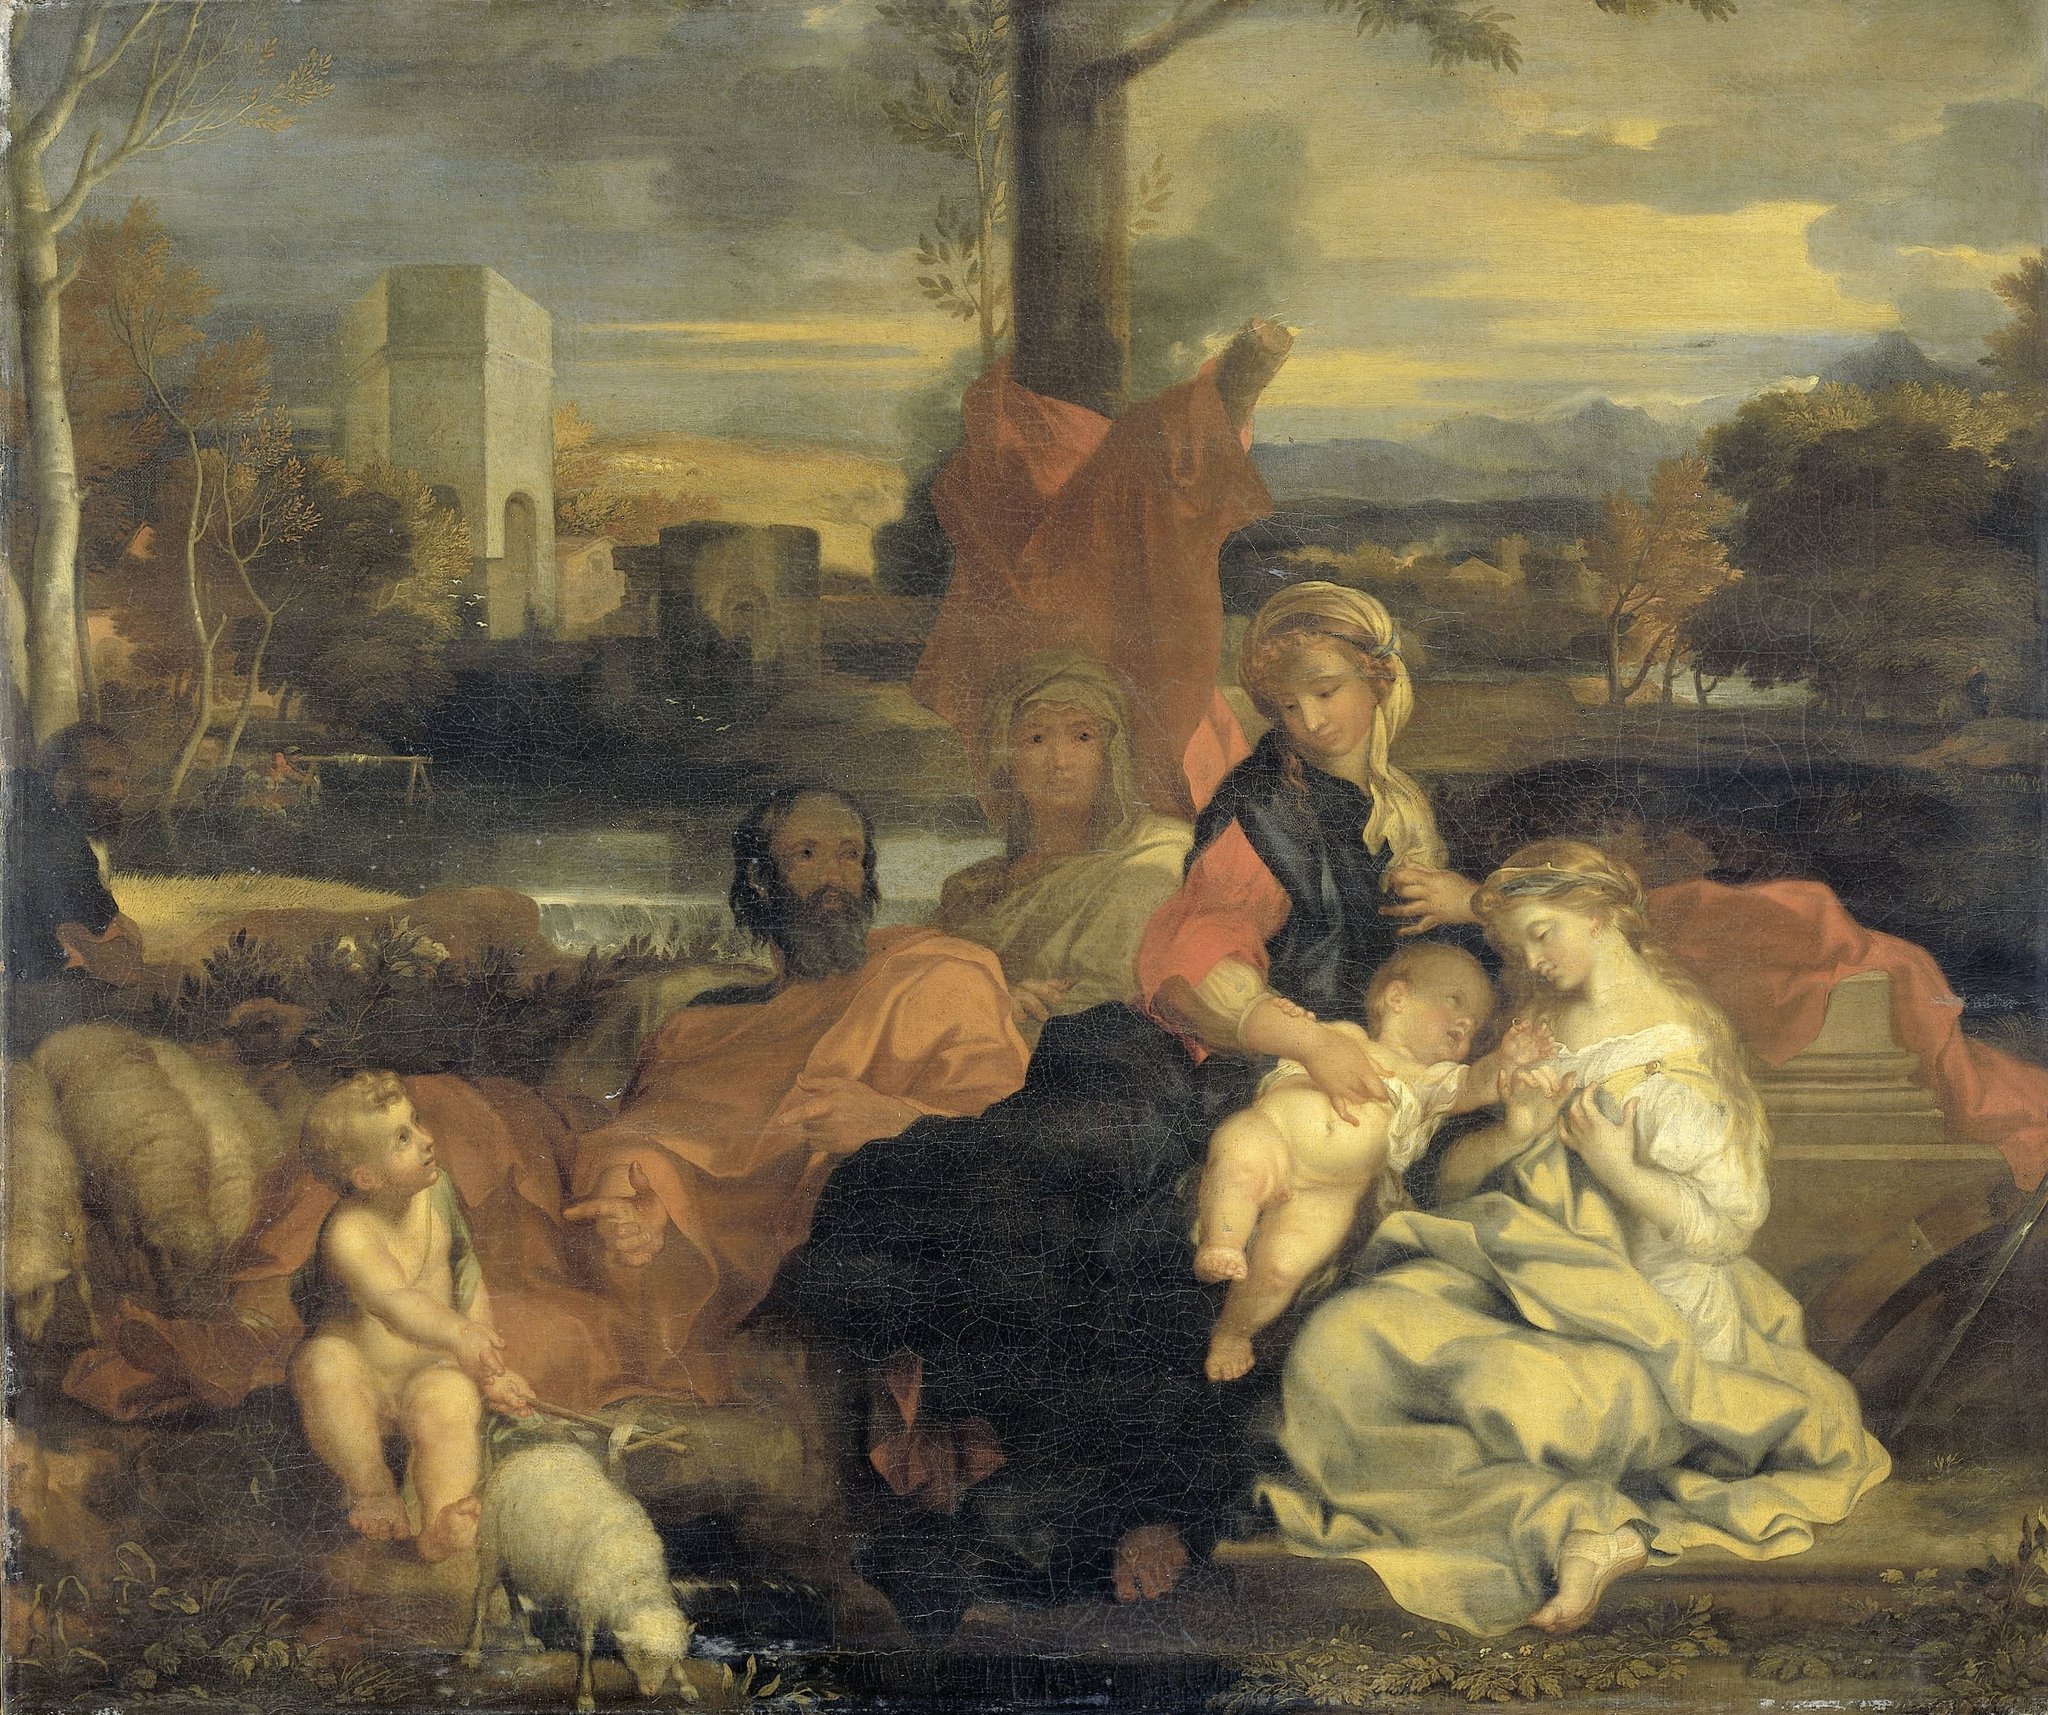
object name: painting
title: The Mystic Marriage of St Catherine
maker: jacques-antoine friquet de vauroze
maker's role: print maker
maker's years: 1638-1716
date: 1650-1720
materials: canvas, oil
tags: the mystic marriage of st. catherine of alexandria with the infant christ: the christ-child puts a ring on her finger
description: Het mystieke huwelijk van de heilige Catharina. Rechts Catharina met het Christuskind; midden en links Maria, Jozef, Anna en Johannes de Doper als kind met een kudde schapen. Op de achtergrond een landschap met bouwwerken en ruïnes aan het water.